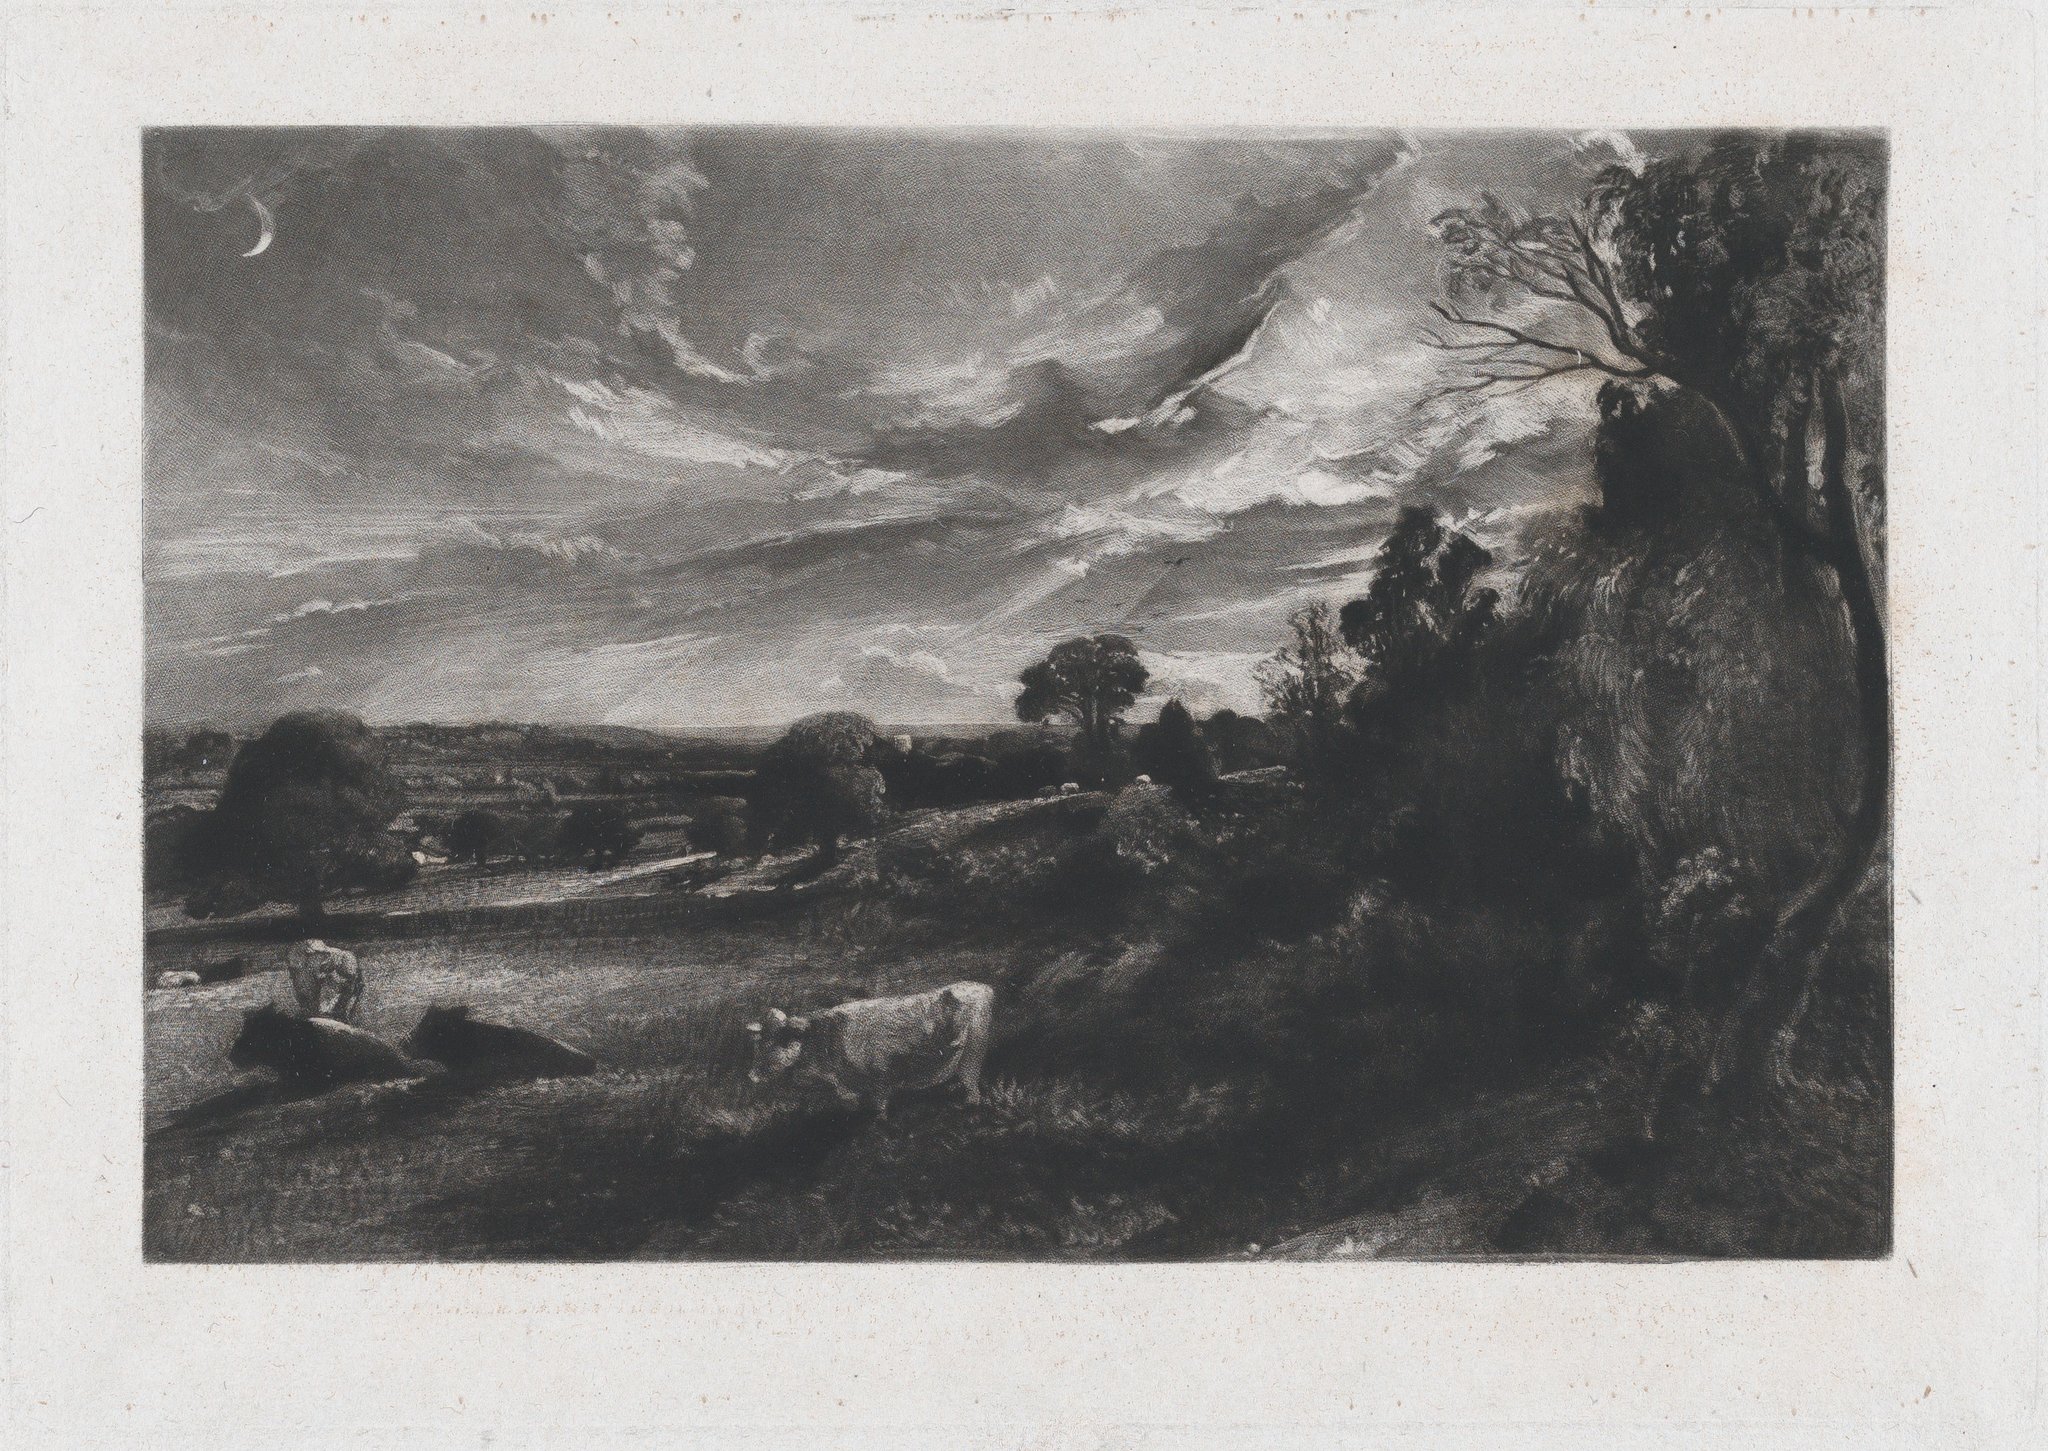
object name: print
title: Summer Evening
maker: david lucas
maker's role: artist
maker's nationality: british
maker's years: 1802-1881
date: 1829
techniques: mezzotint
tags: cows,landscapes,summer,evening